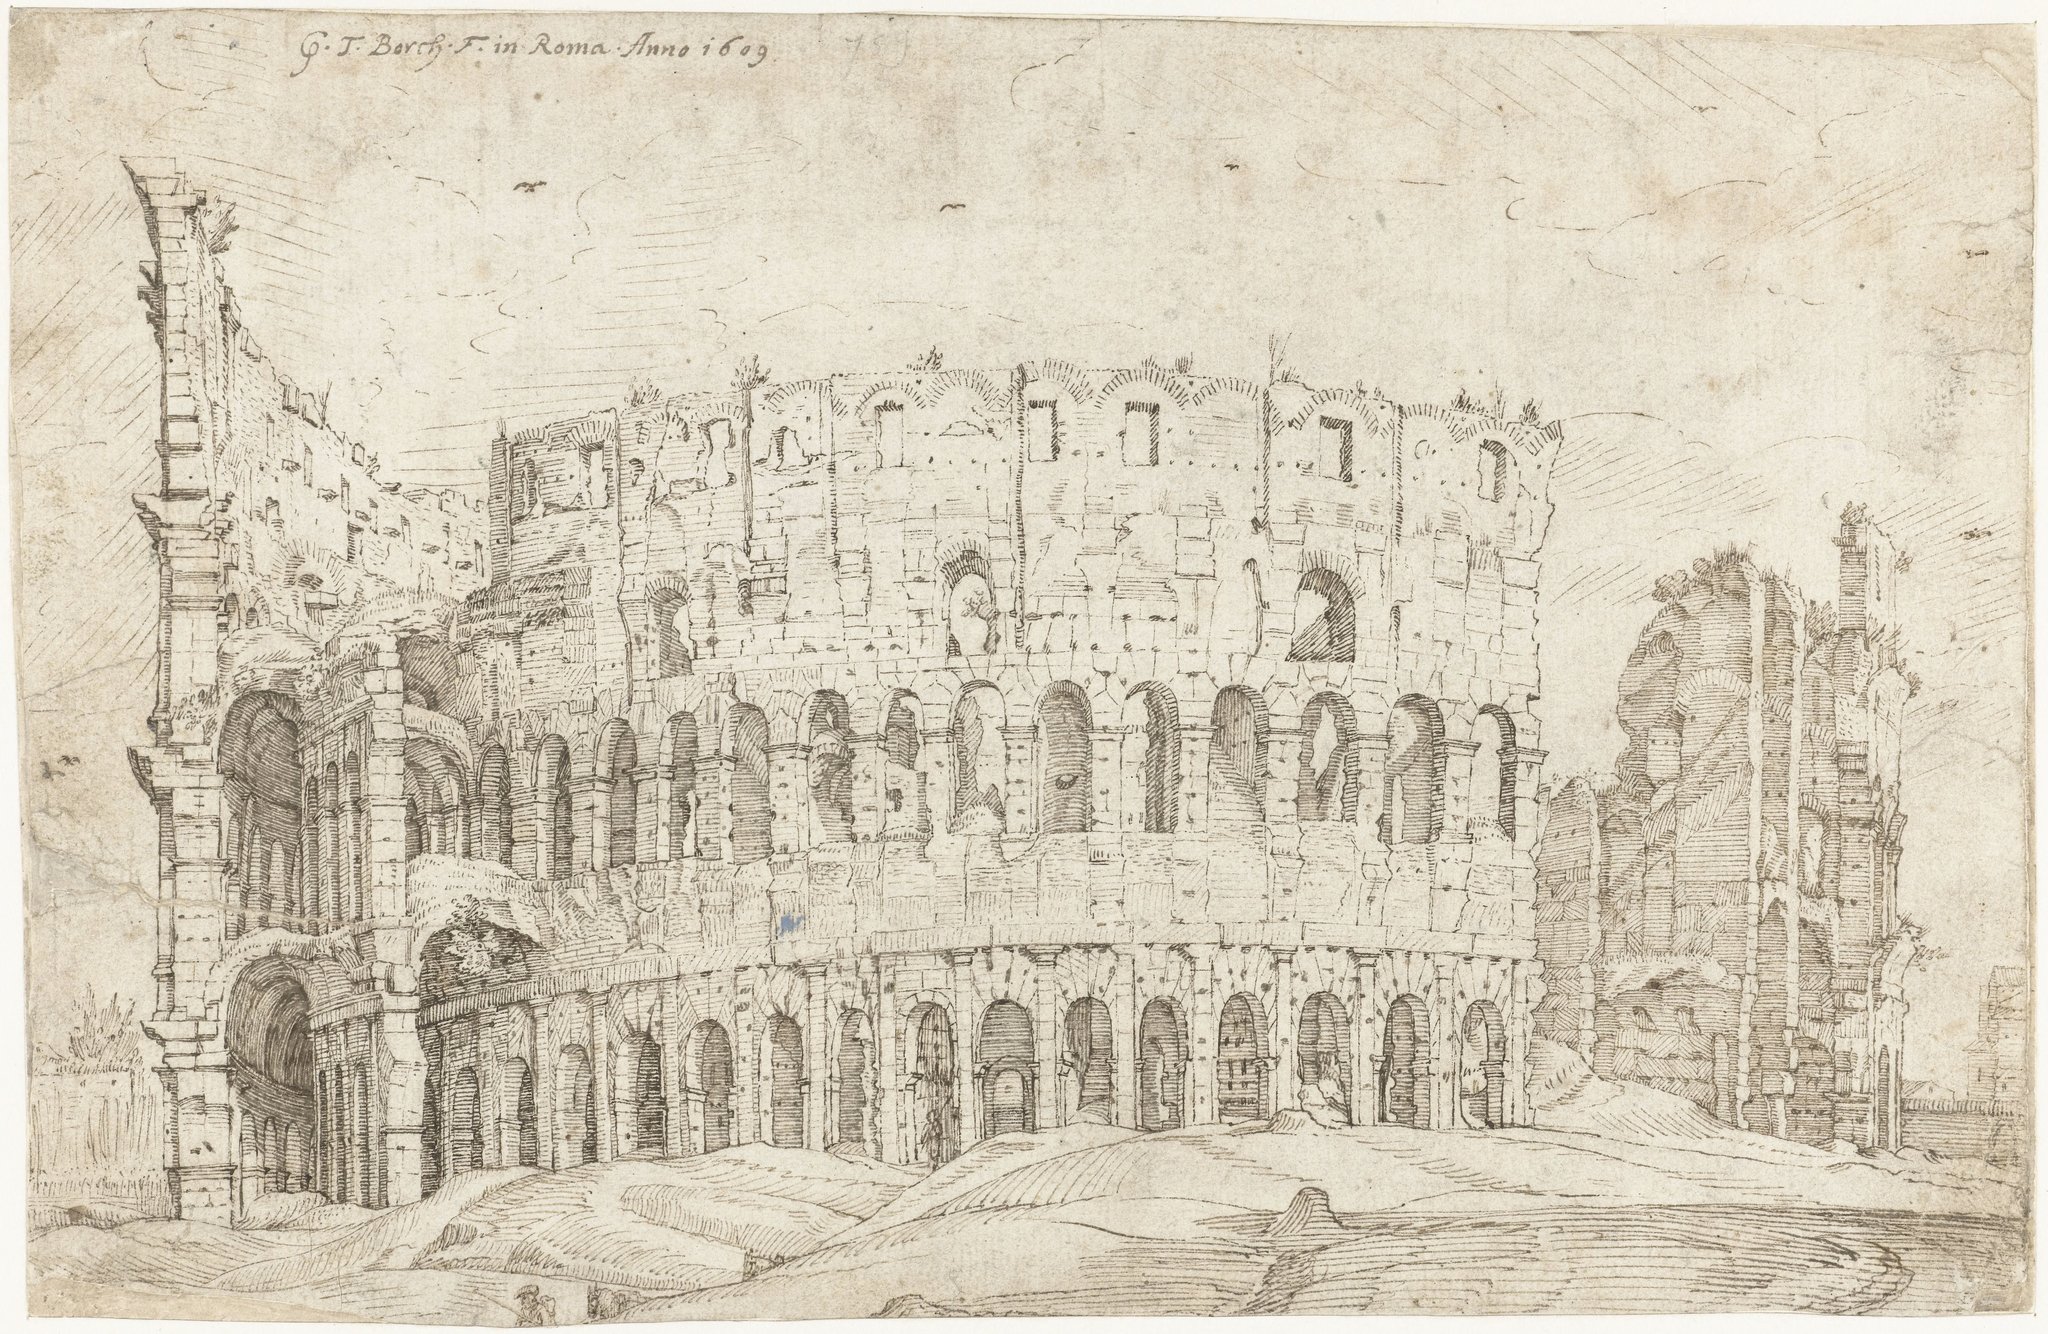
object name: drawing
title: Exterior of the ruins of the Colosseum, Rome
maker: gerard ter borch (i)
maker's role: draughtsman, print maker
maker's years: 1584-1662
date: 1609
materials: ink, paper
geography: rome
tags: colosseum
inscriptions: signature and date: ‘G.T.Borch.F. in Roma. Anno 1609’, annotation: ‘G. Ter Borch Sr’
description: Tekening uit het Romeinse schetsboek van de kunstenaar.